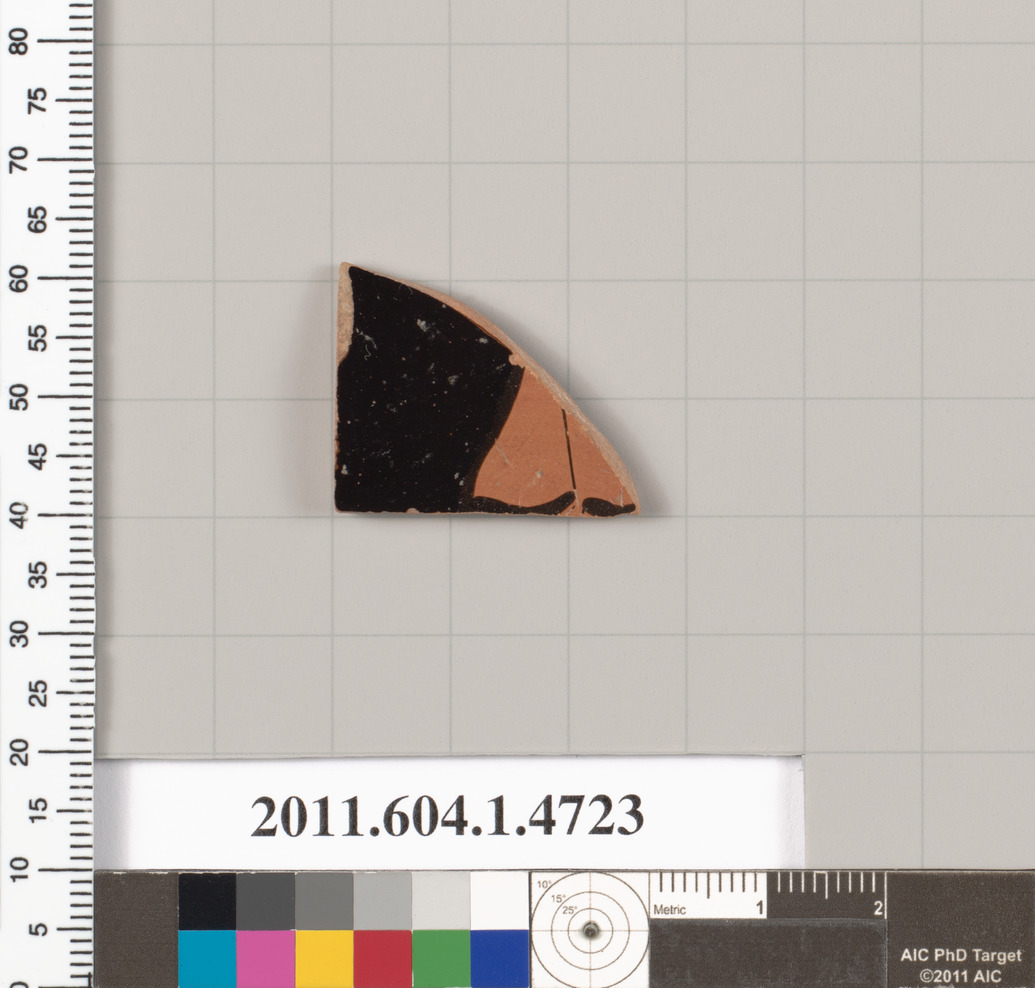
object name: kylix fragment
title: Terracotta fragment of a kylix (drinking cup)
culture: greek, attic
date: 475-451 BCE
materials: terracotta